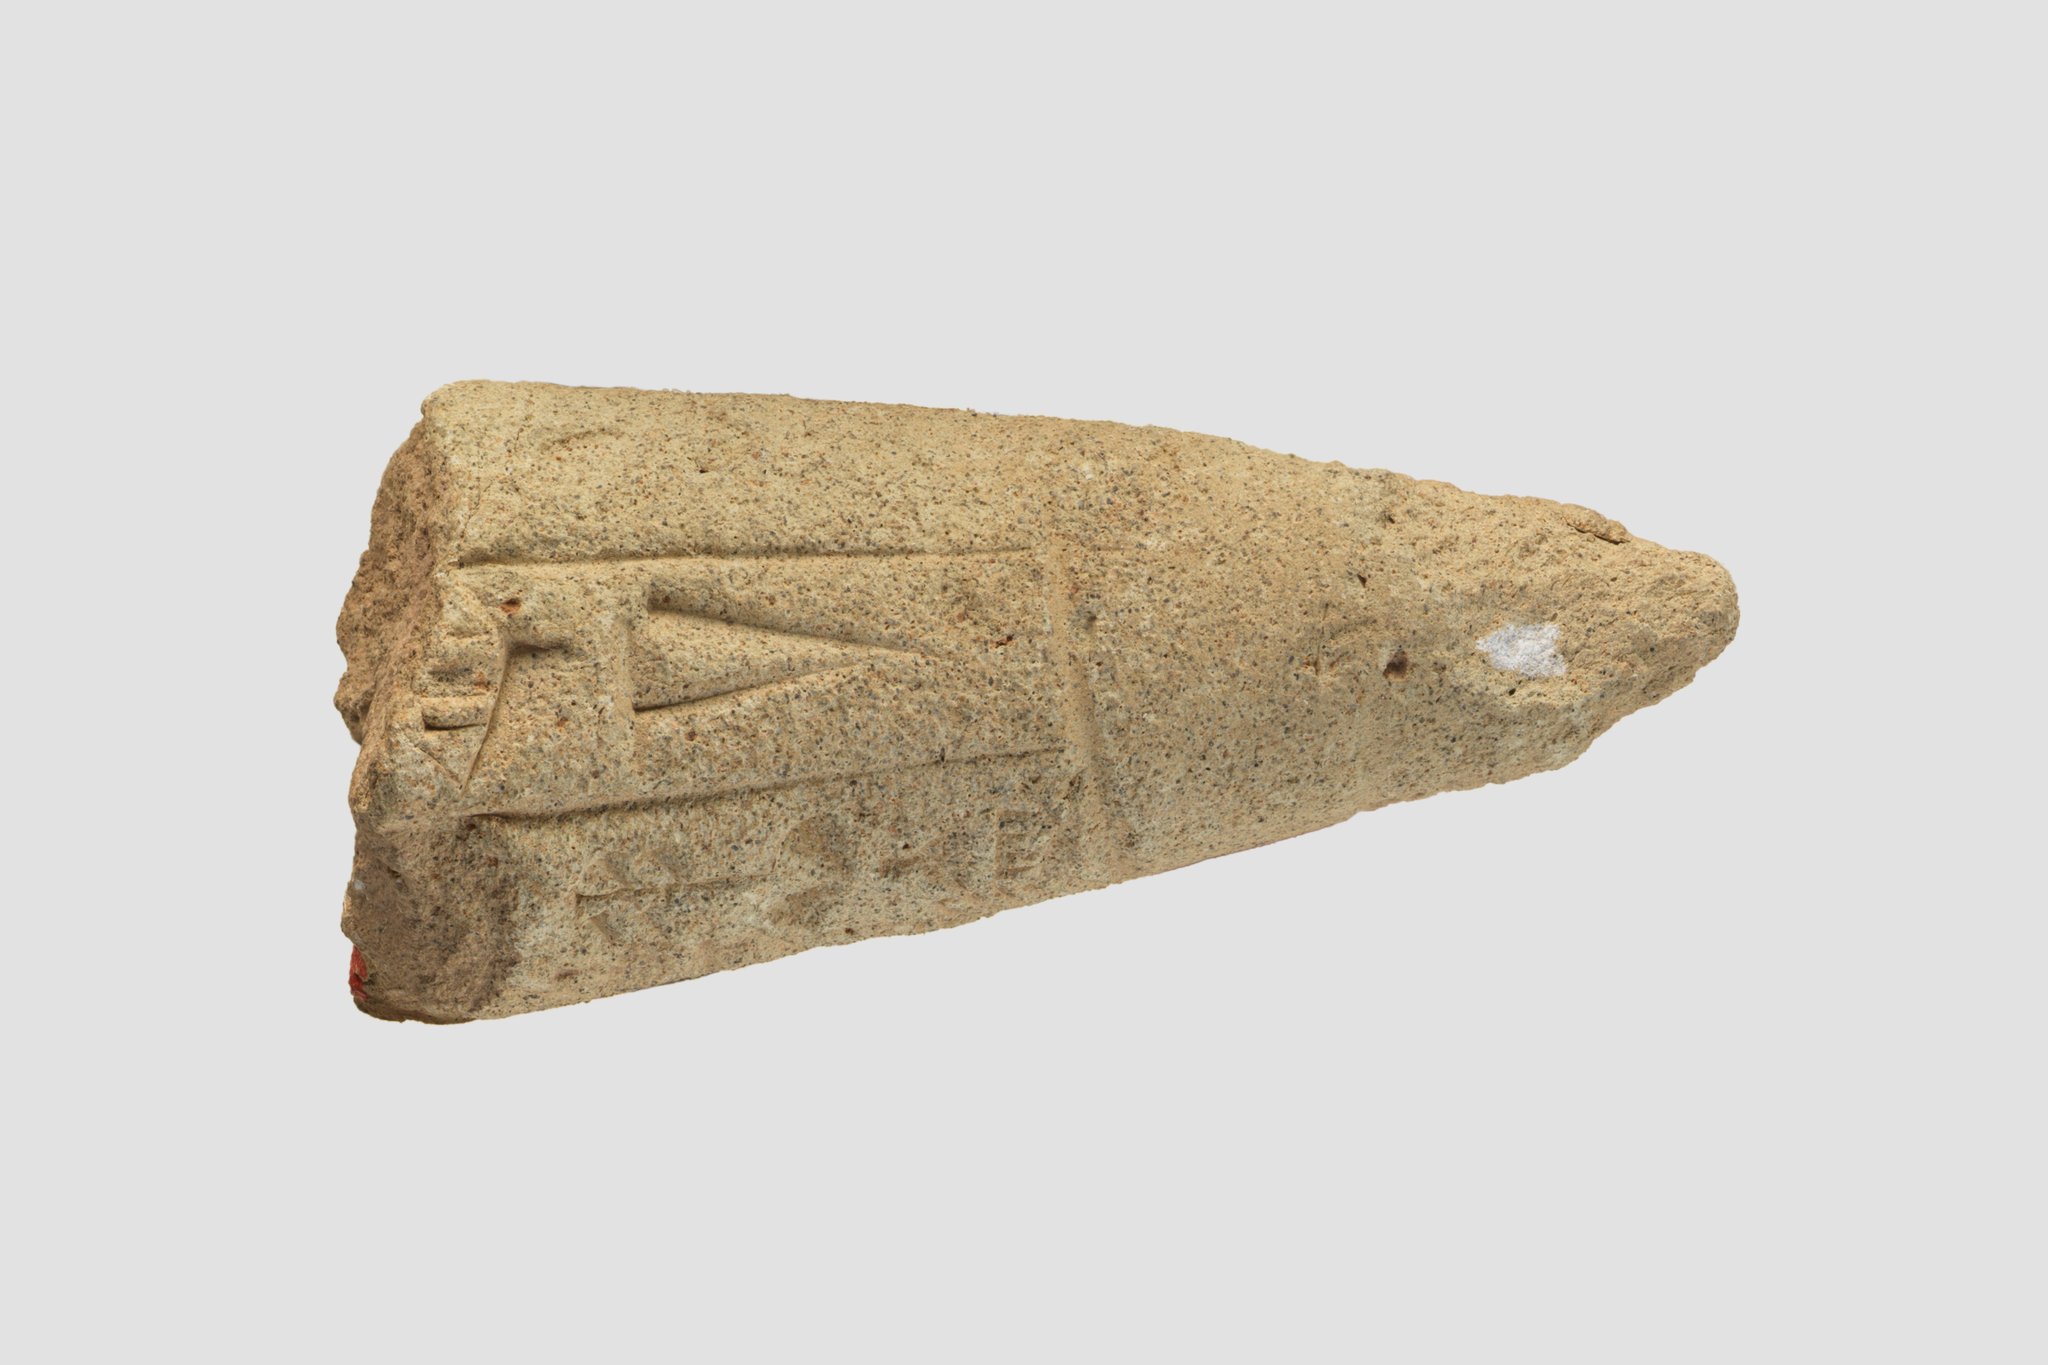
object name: cuneiform cone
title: Votive cone with cuneiform inscription of Gudea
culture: neo-sumerian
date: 2090 BCE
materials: clay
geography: mesopotamia